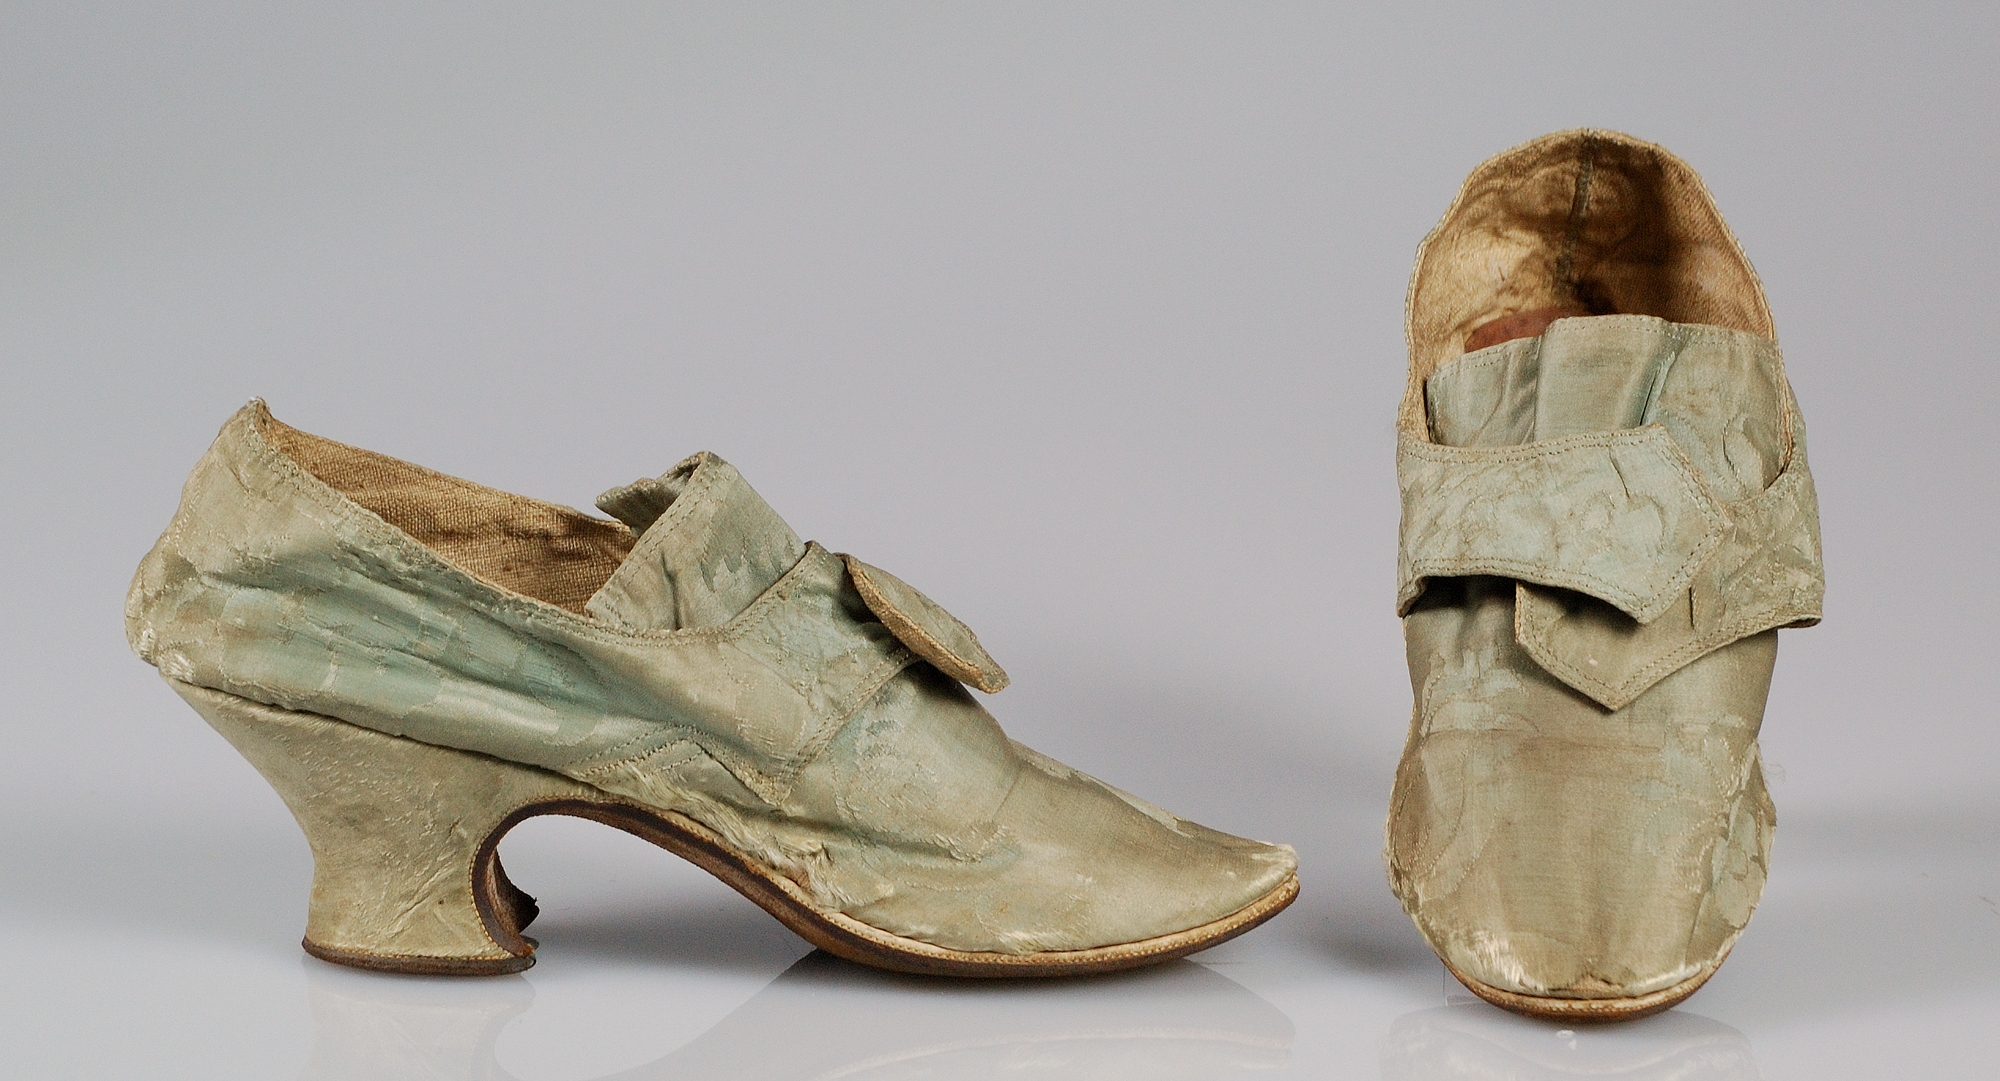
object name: shoe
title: Shoes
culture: british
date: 1740-1760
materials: silk